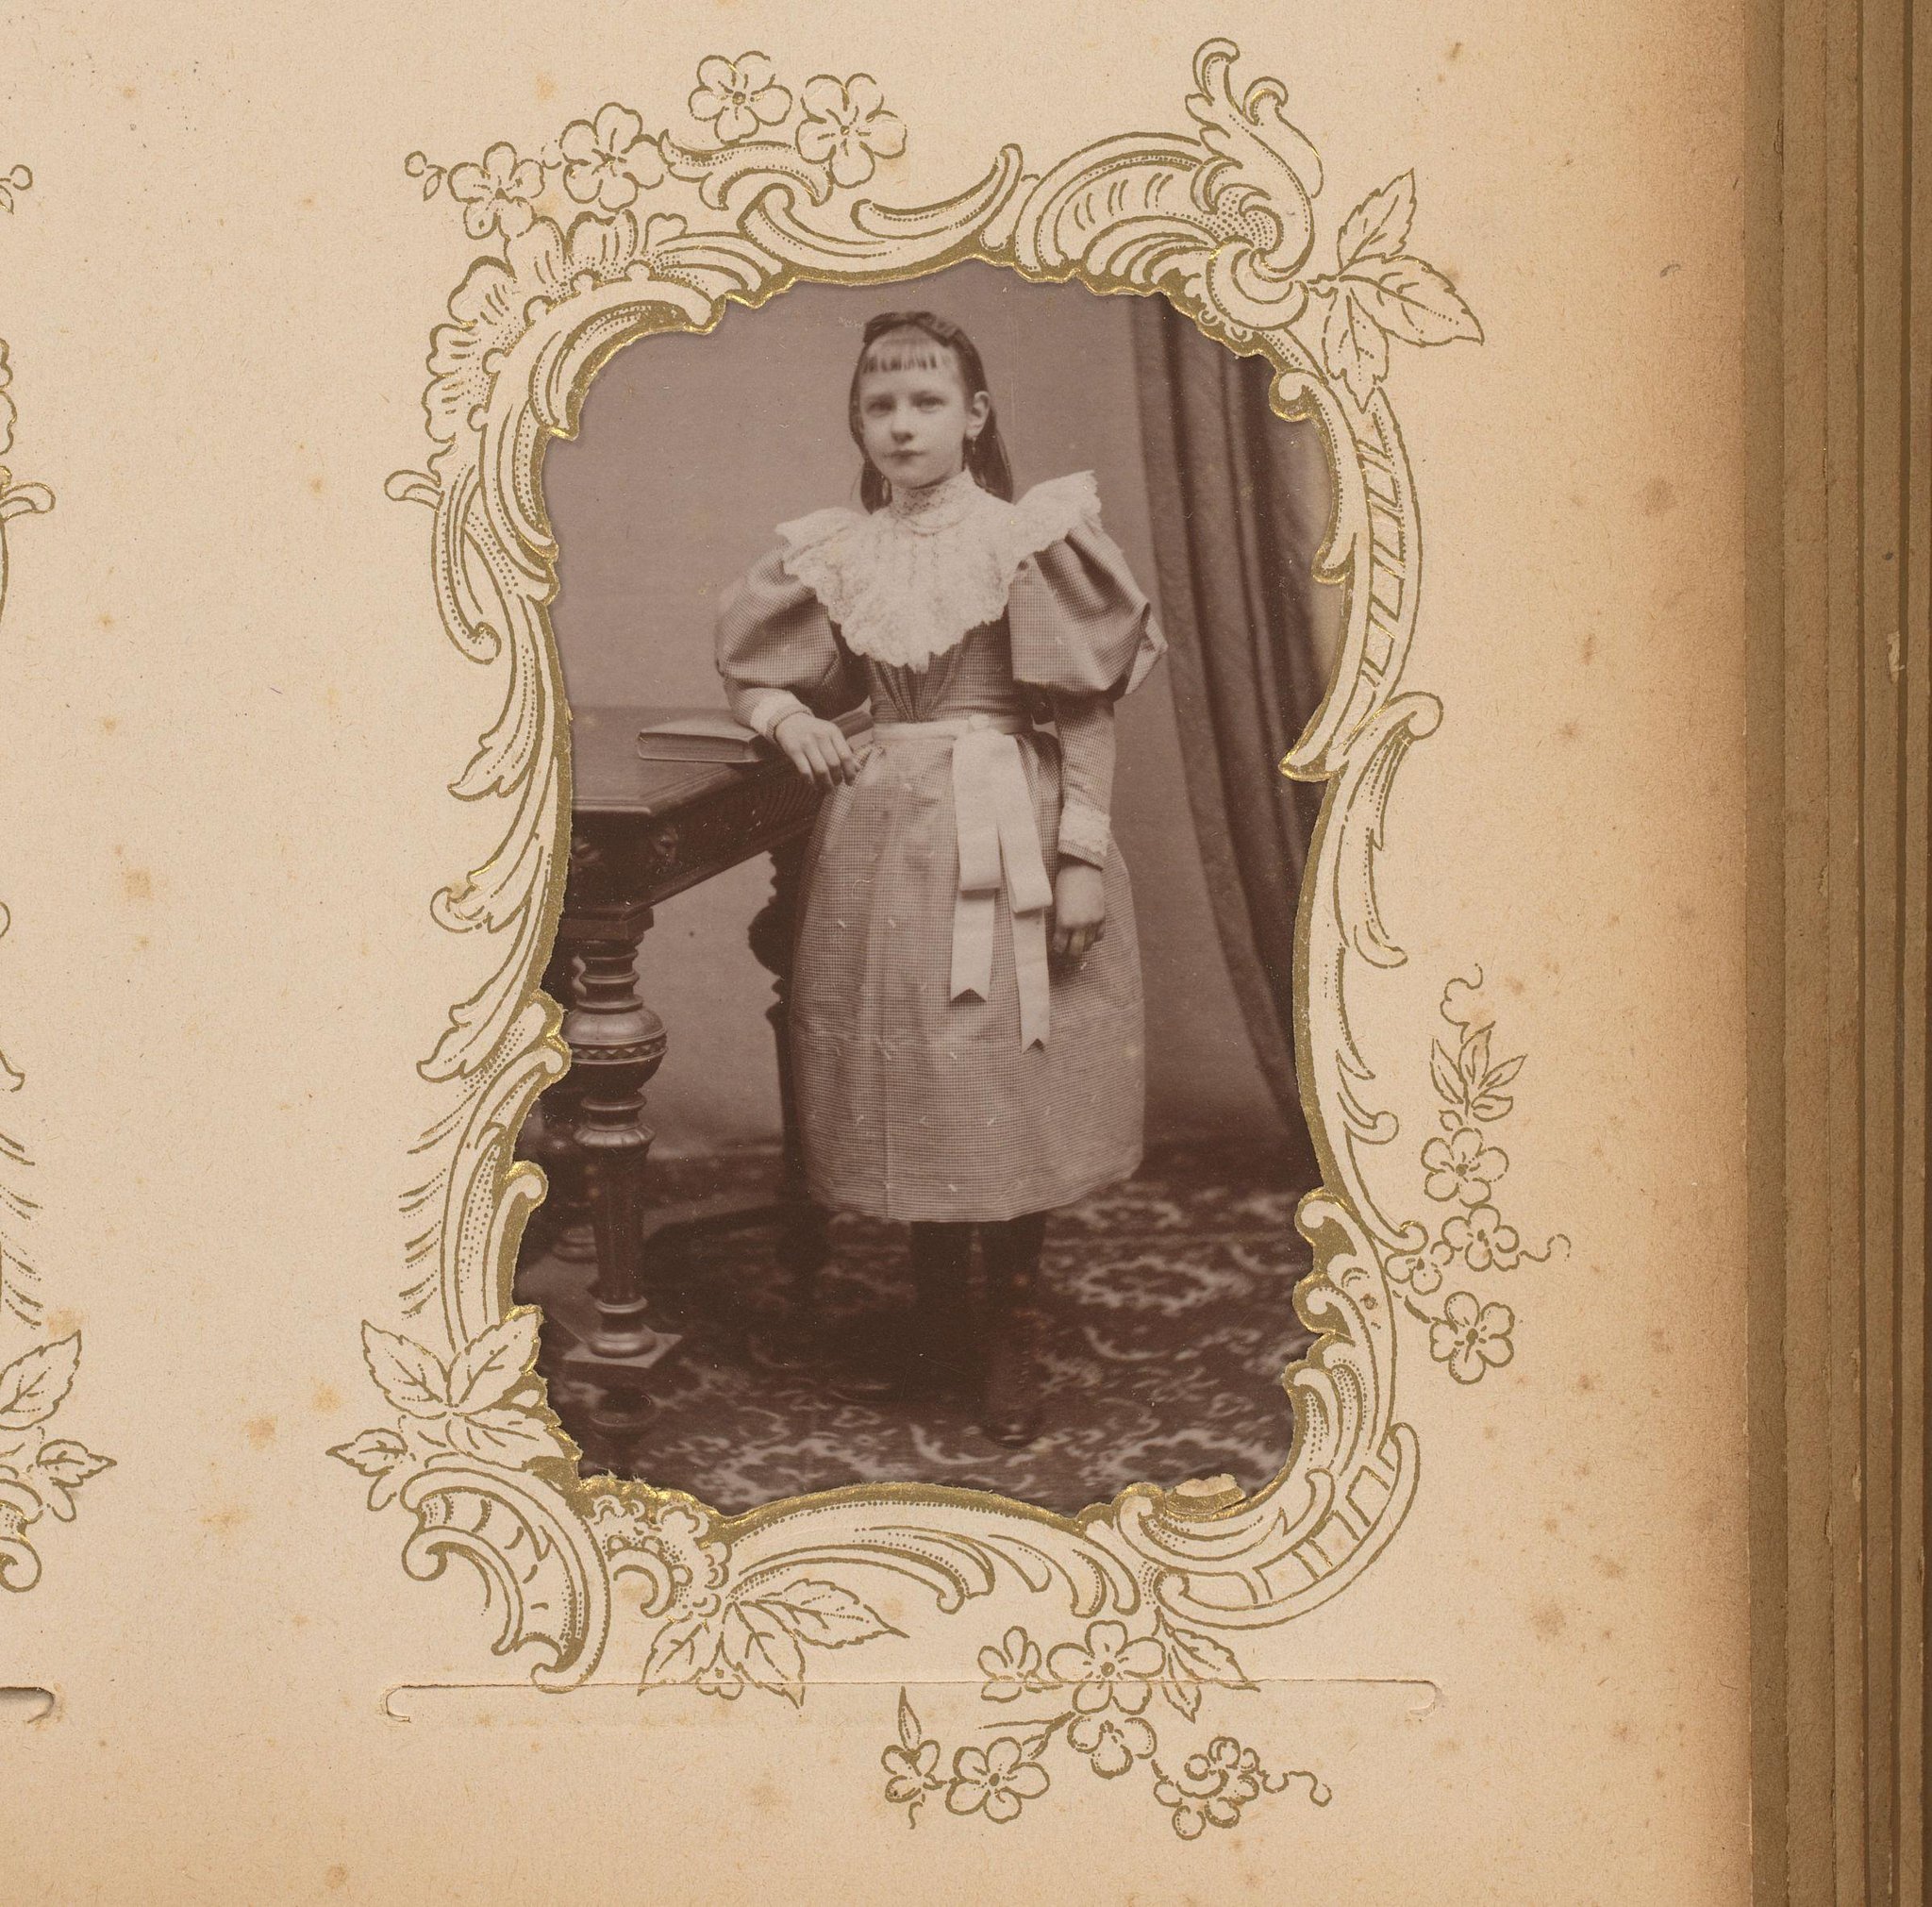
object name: album leaf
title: Portret van een meisje, staand bij een tafel met boek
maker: Anonymous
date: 1870-1890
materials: cardboard, photographic support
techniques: albumen print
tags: historical persons - bb - woman, girl (child between toddler and youth), standing figure - aa - female human figure